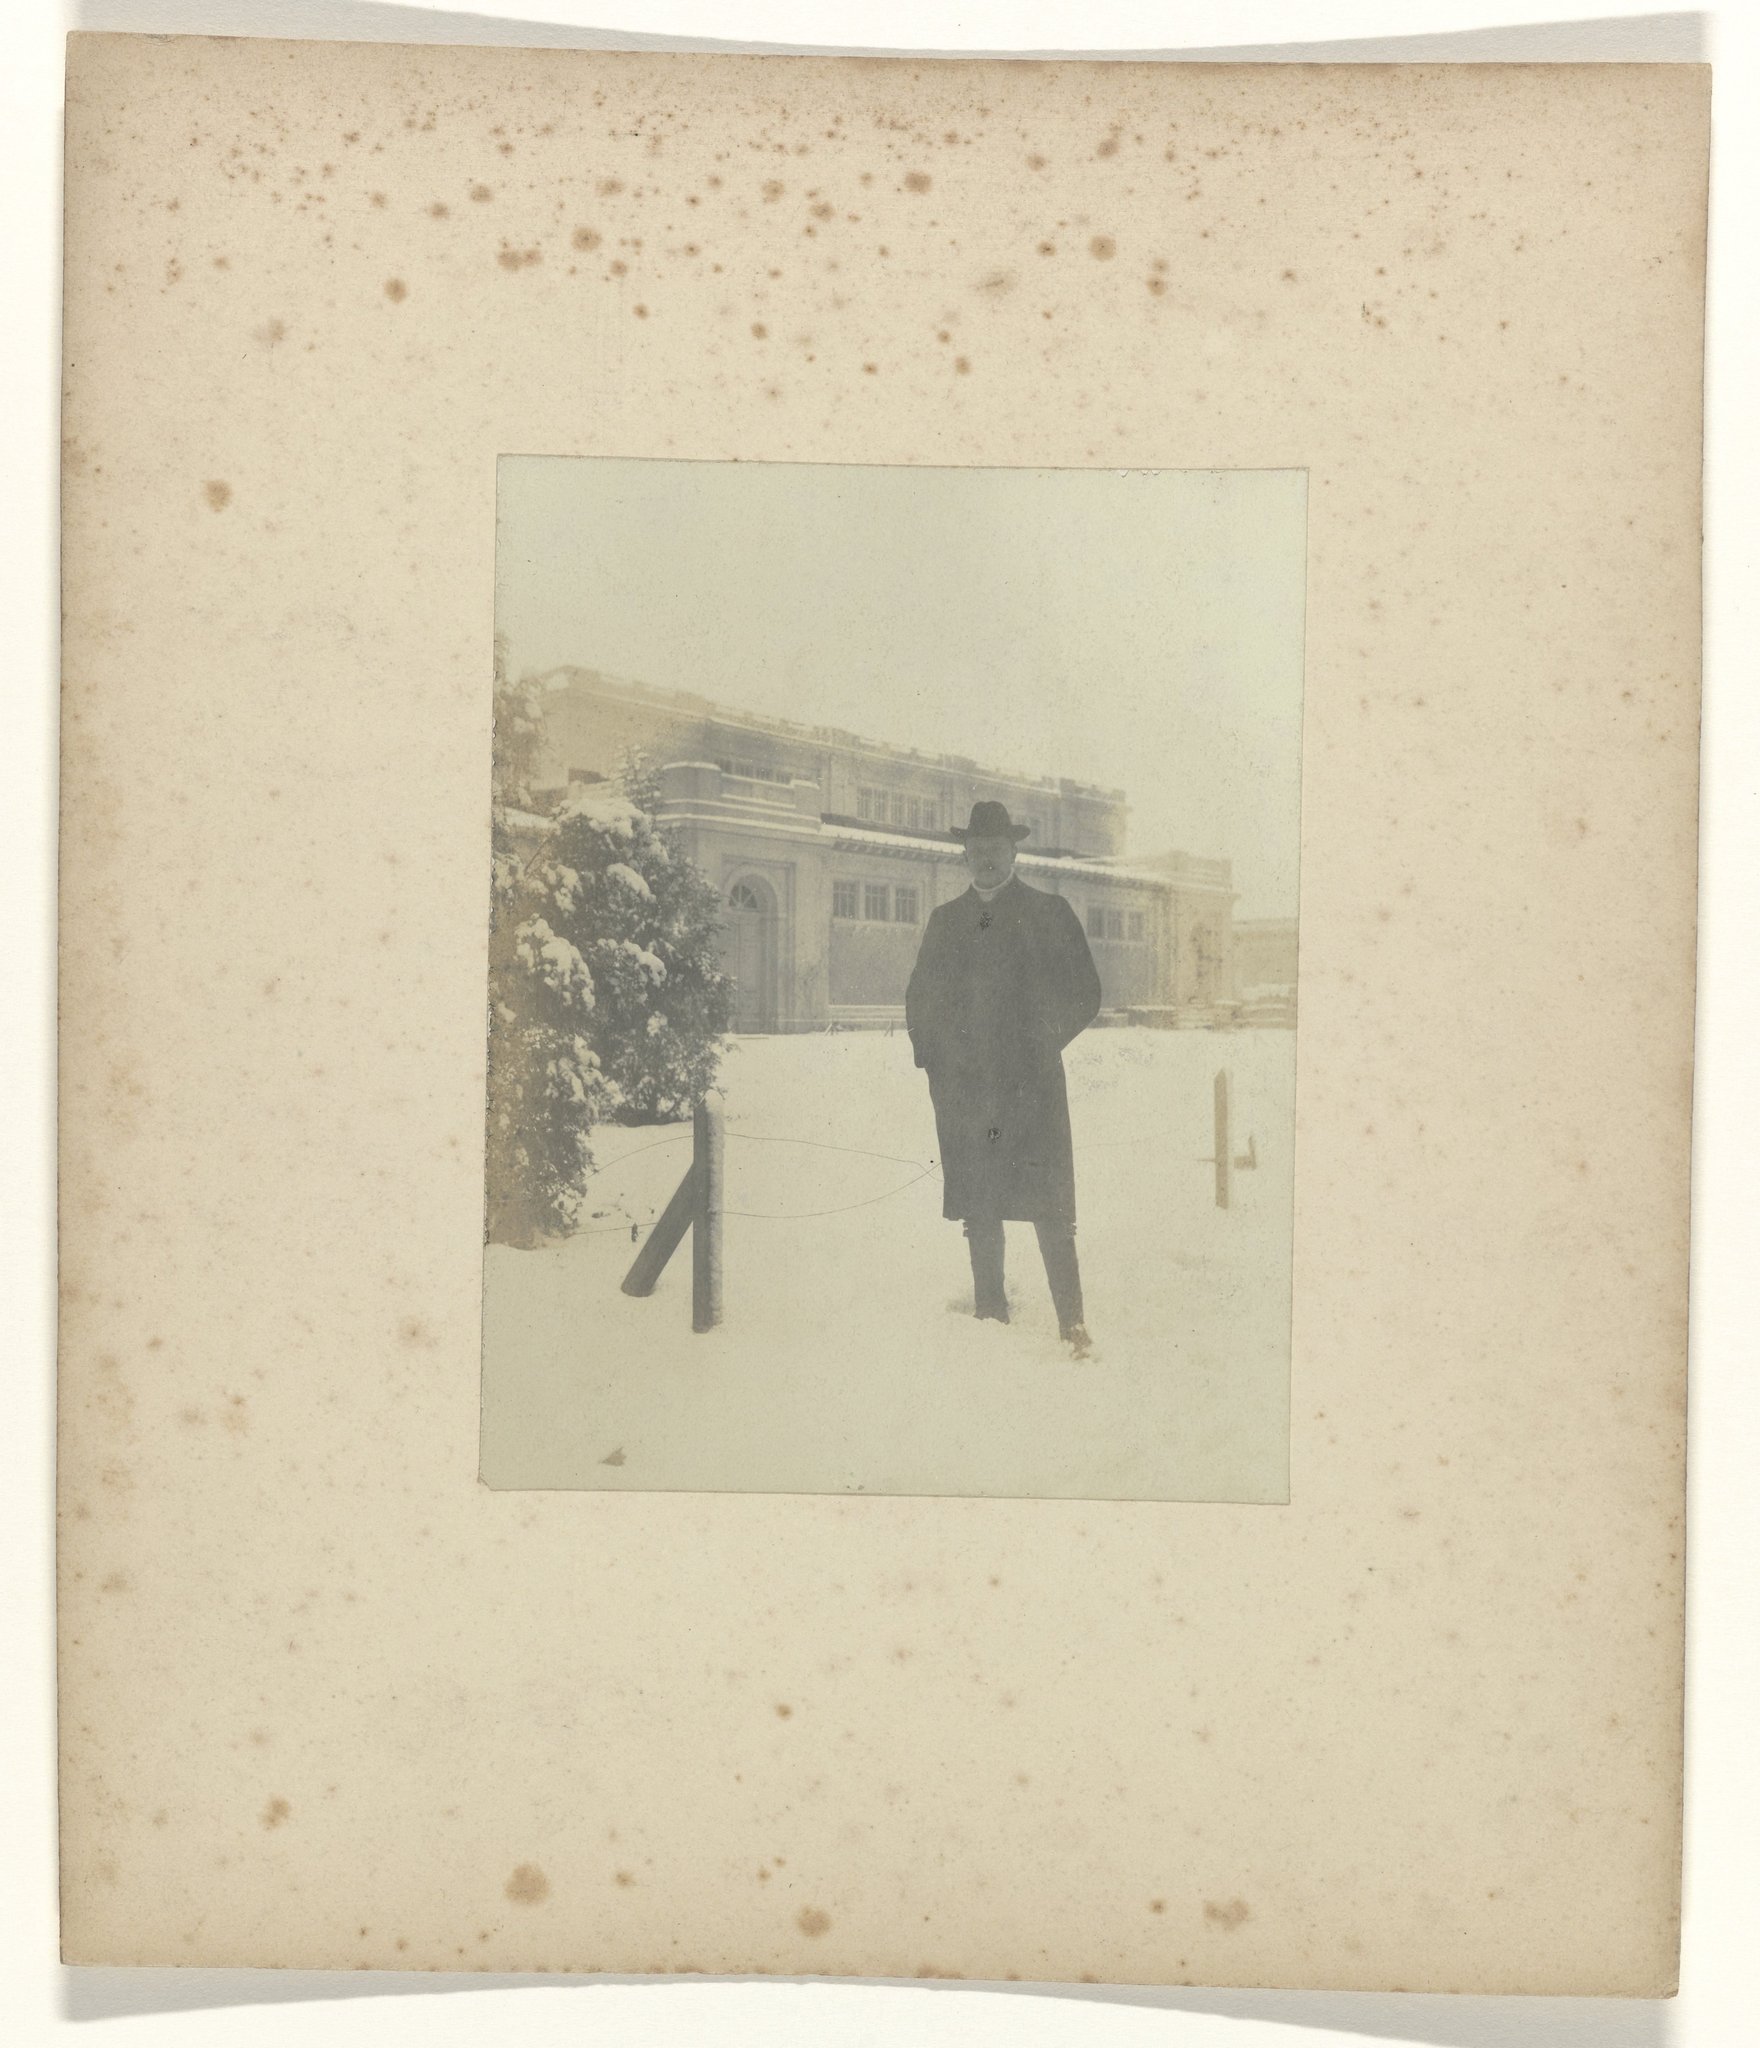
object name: photograph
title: Jan Catharinus Schüller op het terrein van de wereldtentoonstelling in St. Louis (Louisiana Purchase Exposition), 1904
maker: Anonymous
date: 1904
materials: cardboard, paper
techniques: gelatin silver print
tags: print maker, draughtsman, jan schüller, world fair, world exhibition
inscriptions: annotation: ‘Vader’, annotation: ‘Met rijlaarzen etc’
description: Jan Catharinus Schüller op het terrein van de wereldtentoonstelling in St. Louis (Louisiana Purchase Exposition), 1904.